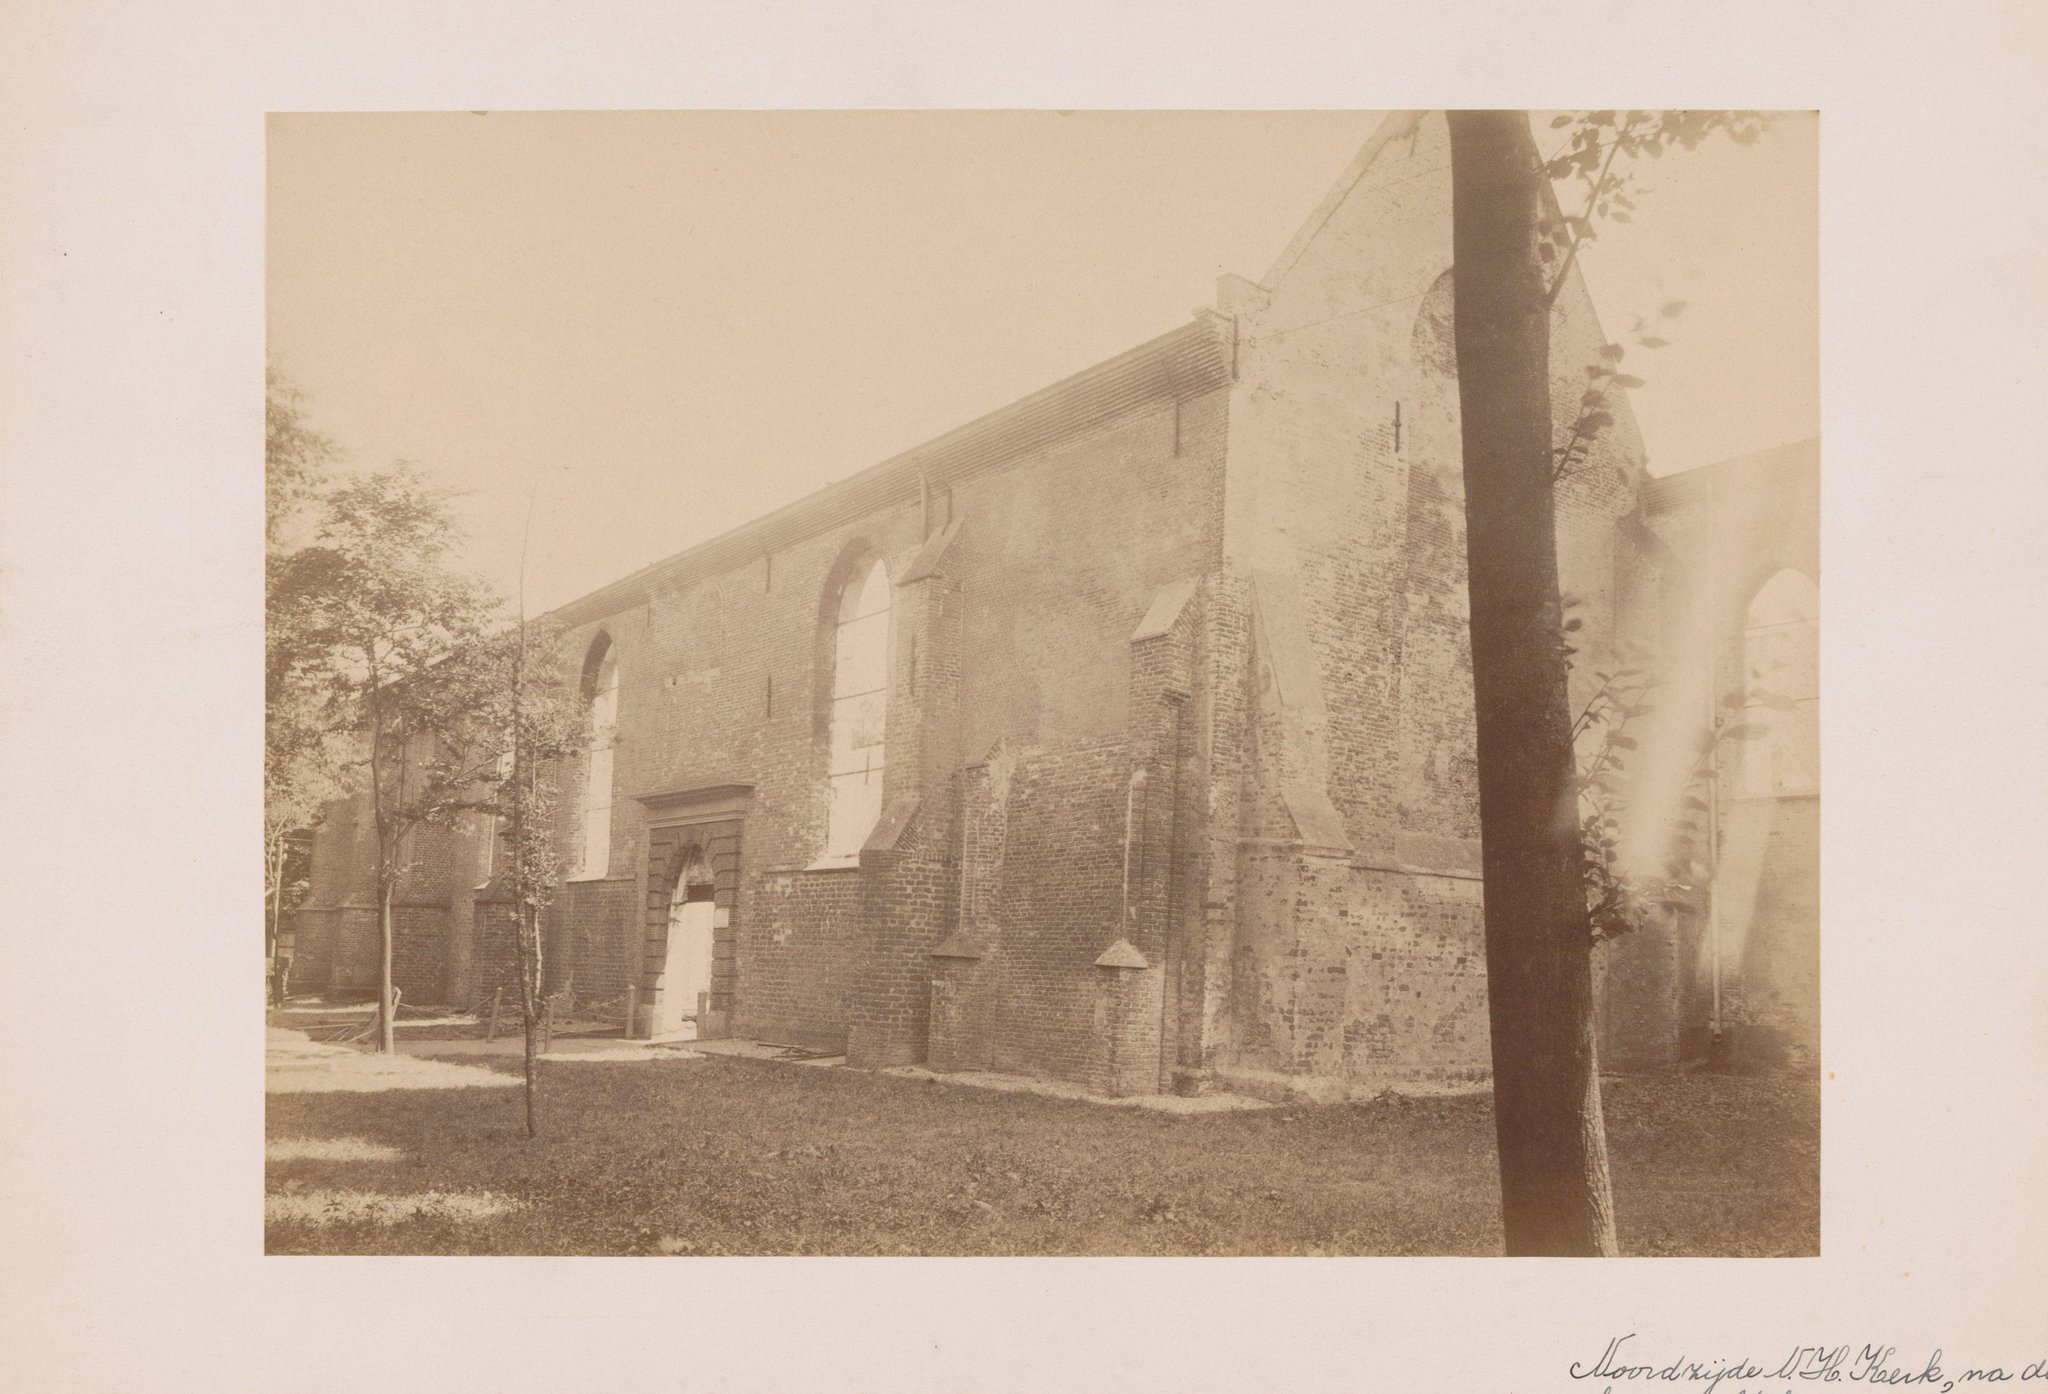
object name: photograph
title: Gezicht op de Hervormde Kerk te Monster na de brand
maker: anoniem (monumentenzorg)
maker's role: fotograaf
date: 1901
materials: cardboard, photographic support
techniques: albumen print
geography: monster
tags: church (exterior)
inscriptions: annotation: ‘Noordzijde N.H. Kerk, na den brand, Juli 1901/ Monster’, annotation: ‘Monster noordzijde N.H. kerk (Z.H.)/ na den brand Juli 1901’